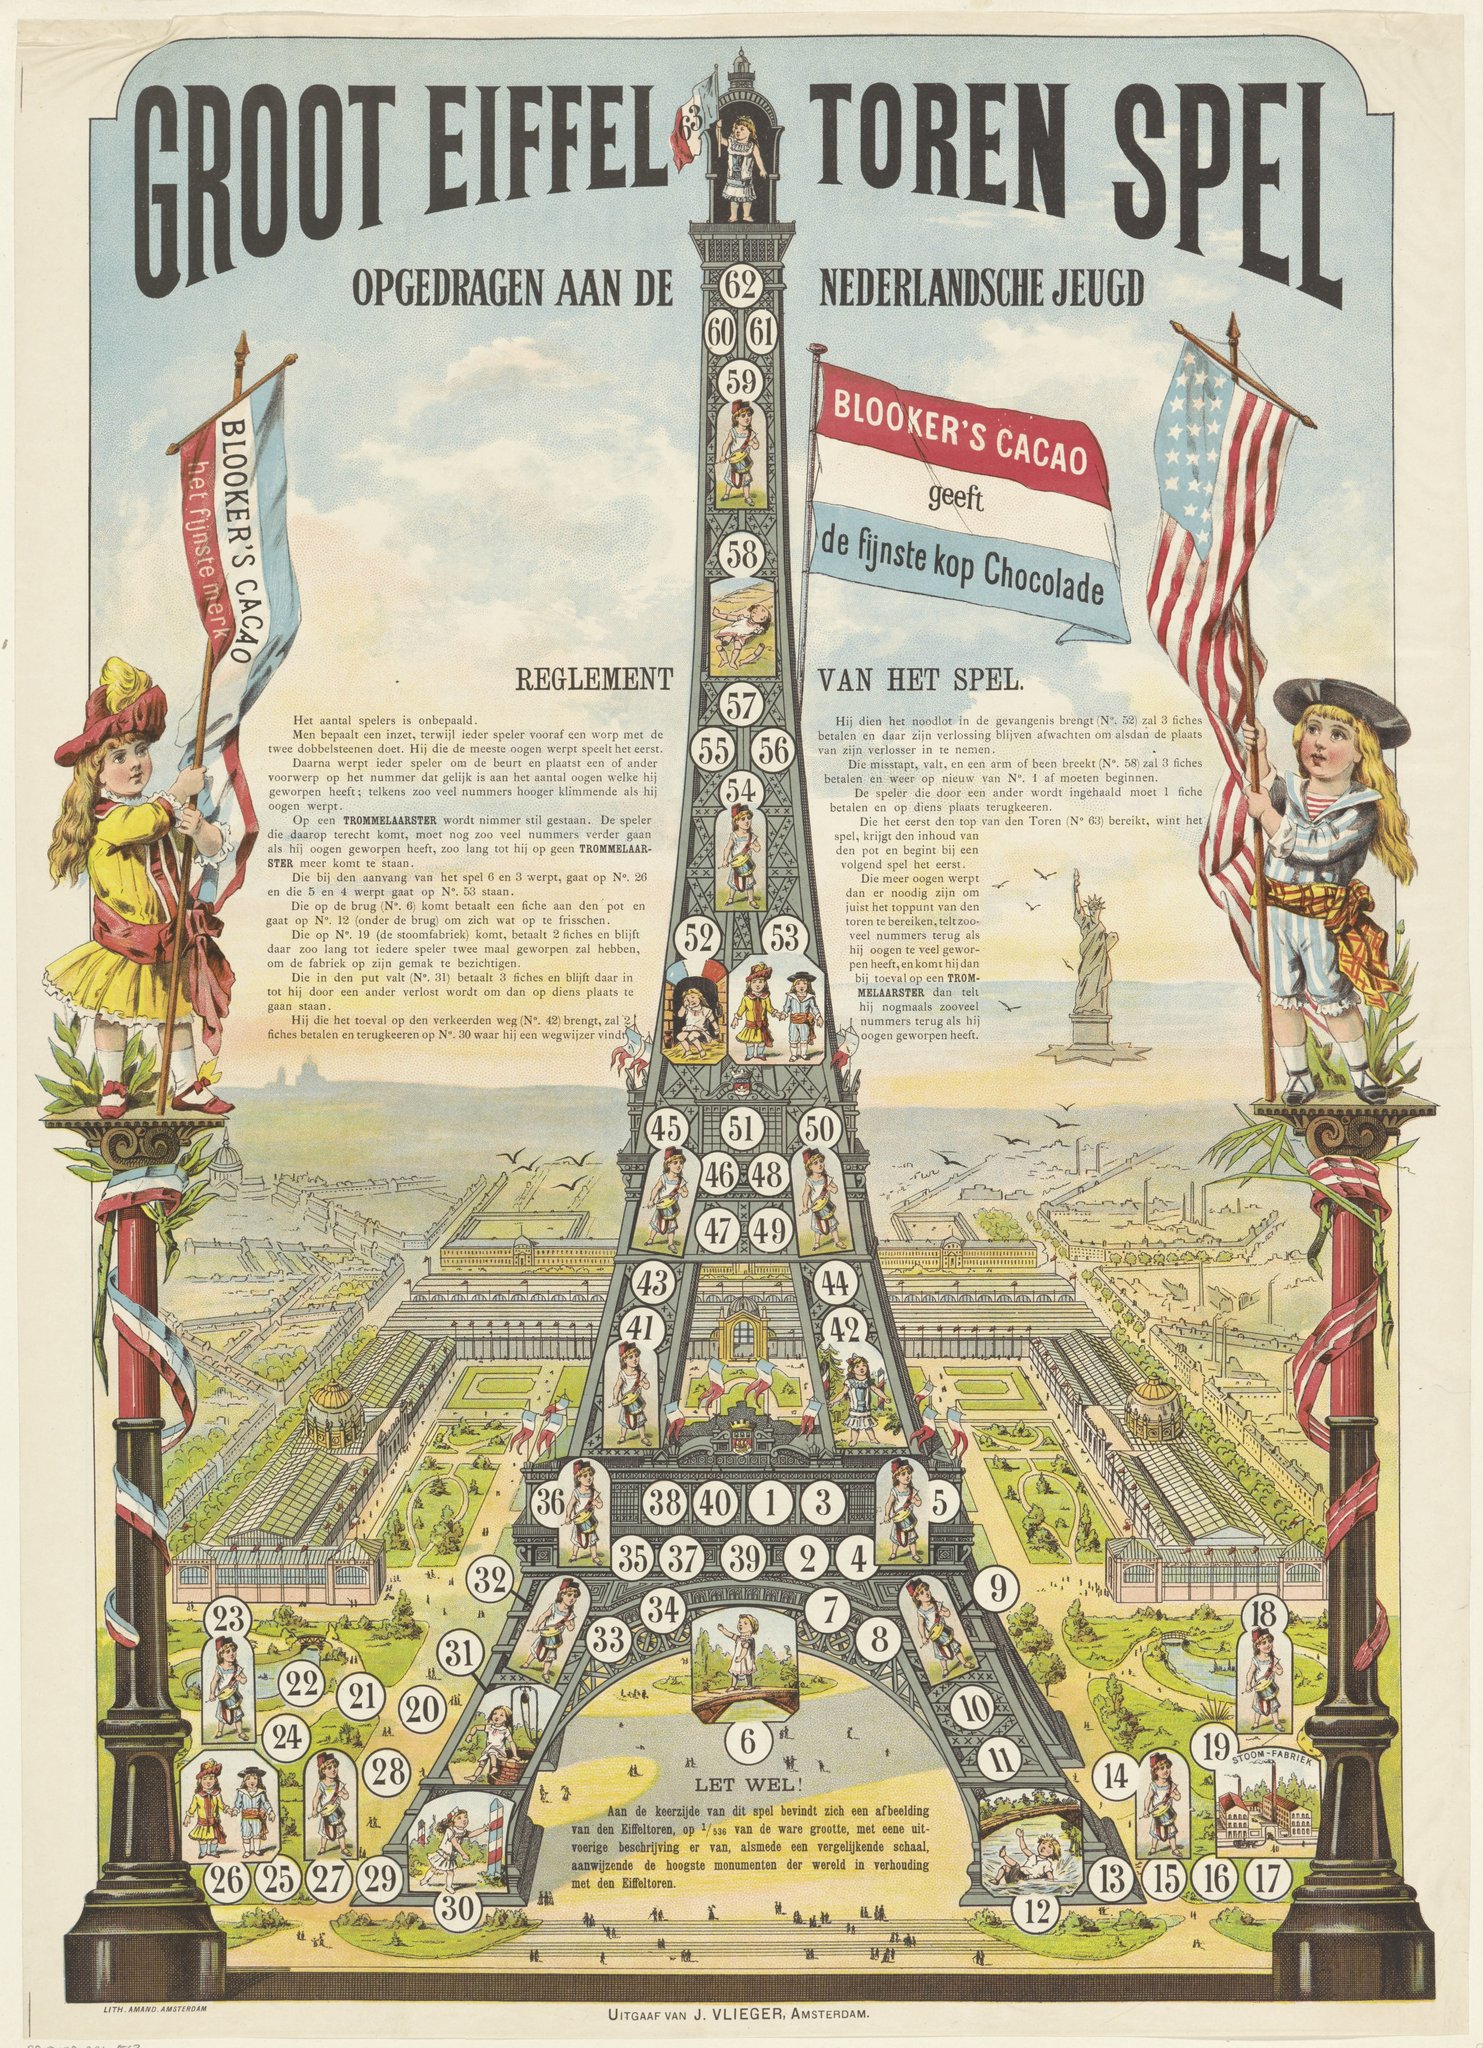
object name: popular print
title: Groot eiffel toren spel / opgedragen aan de Nederlandsche jeugd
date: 1889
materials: paper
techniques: lithograph, letterpress printing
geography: amsterdam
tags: board-games of chance, board-games, statue of liberty, paris, eiffel tower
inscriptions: collector's mark: Lugt 2760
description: Bordspel met rondjes genummerd van 1 tot en met 63, lopend over de Eiffeltoren. Ganzenbordachtig reclamespel, naar aanleiding van de wereldtentoonstelling in Parijs in 1889, voor Blooker's cacao. Links en rechts twee zuilen met een meisjes erop. Het linker meisje draagt de Franse vlag, het rechter meisje draagt de Amerikaanse vlag. Op de achtergrond rechts het Vrijheidsbeeld. Spelregels in boekdruk midden op het blad.